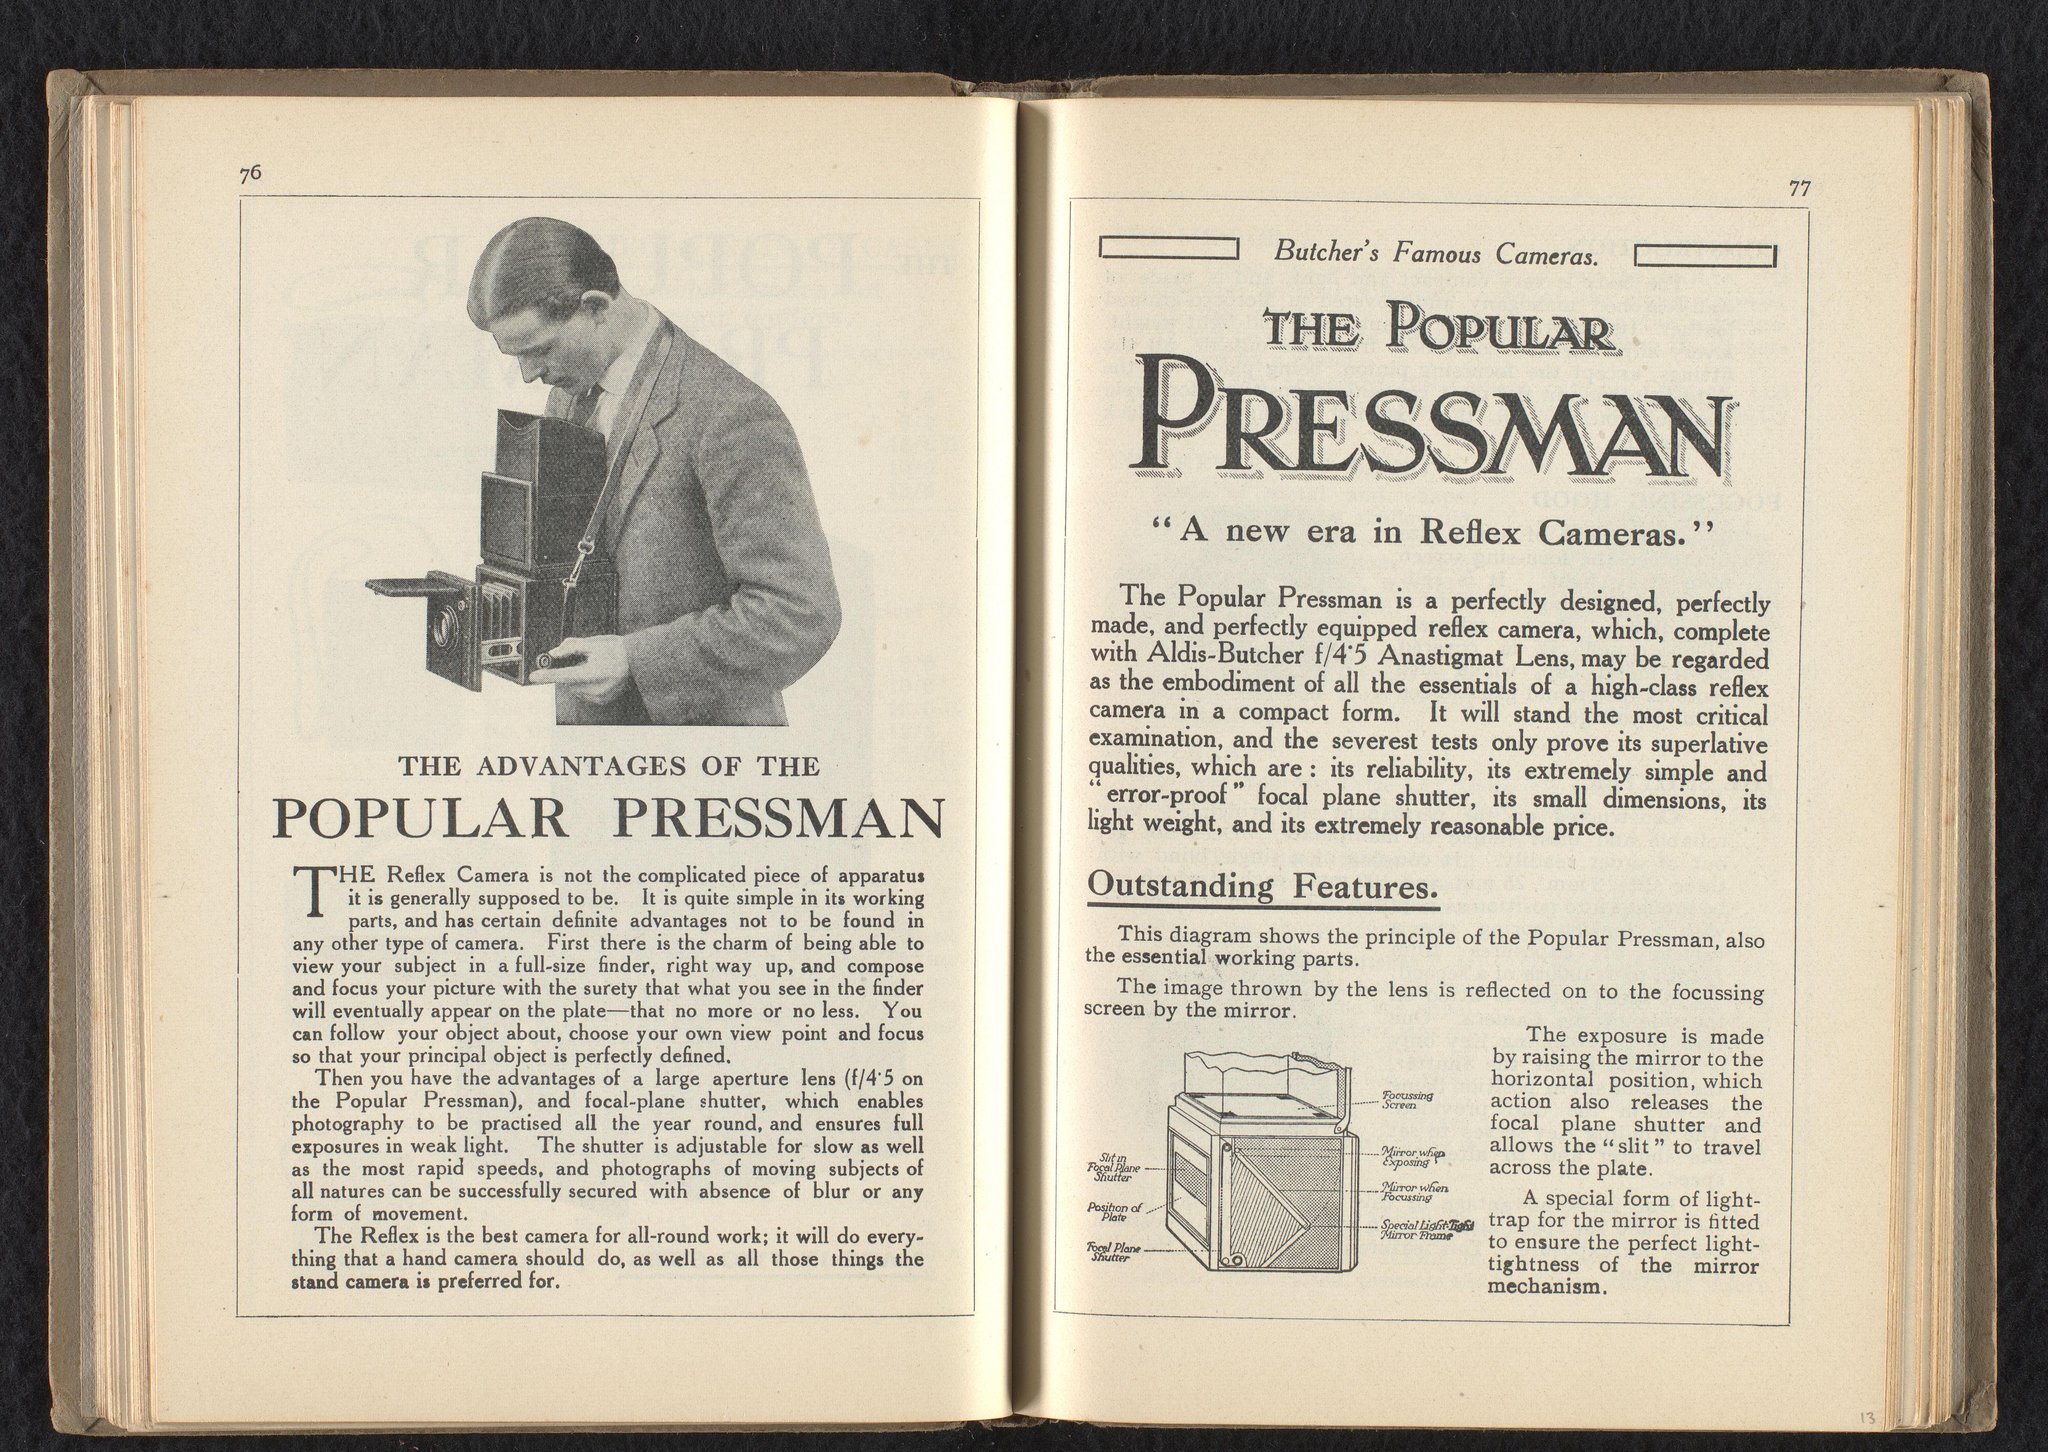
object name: page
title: Man met Popular Pressman Reflex Camera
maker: Anonymous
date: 1907-1912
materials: paper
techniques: letterpress printing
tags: camera ~ photography, historical persons not known by name